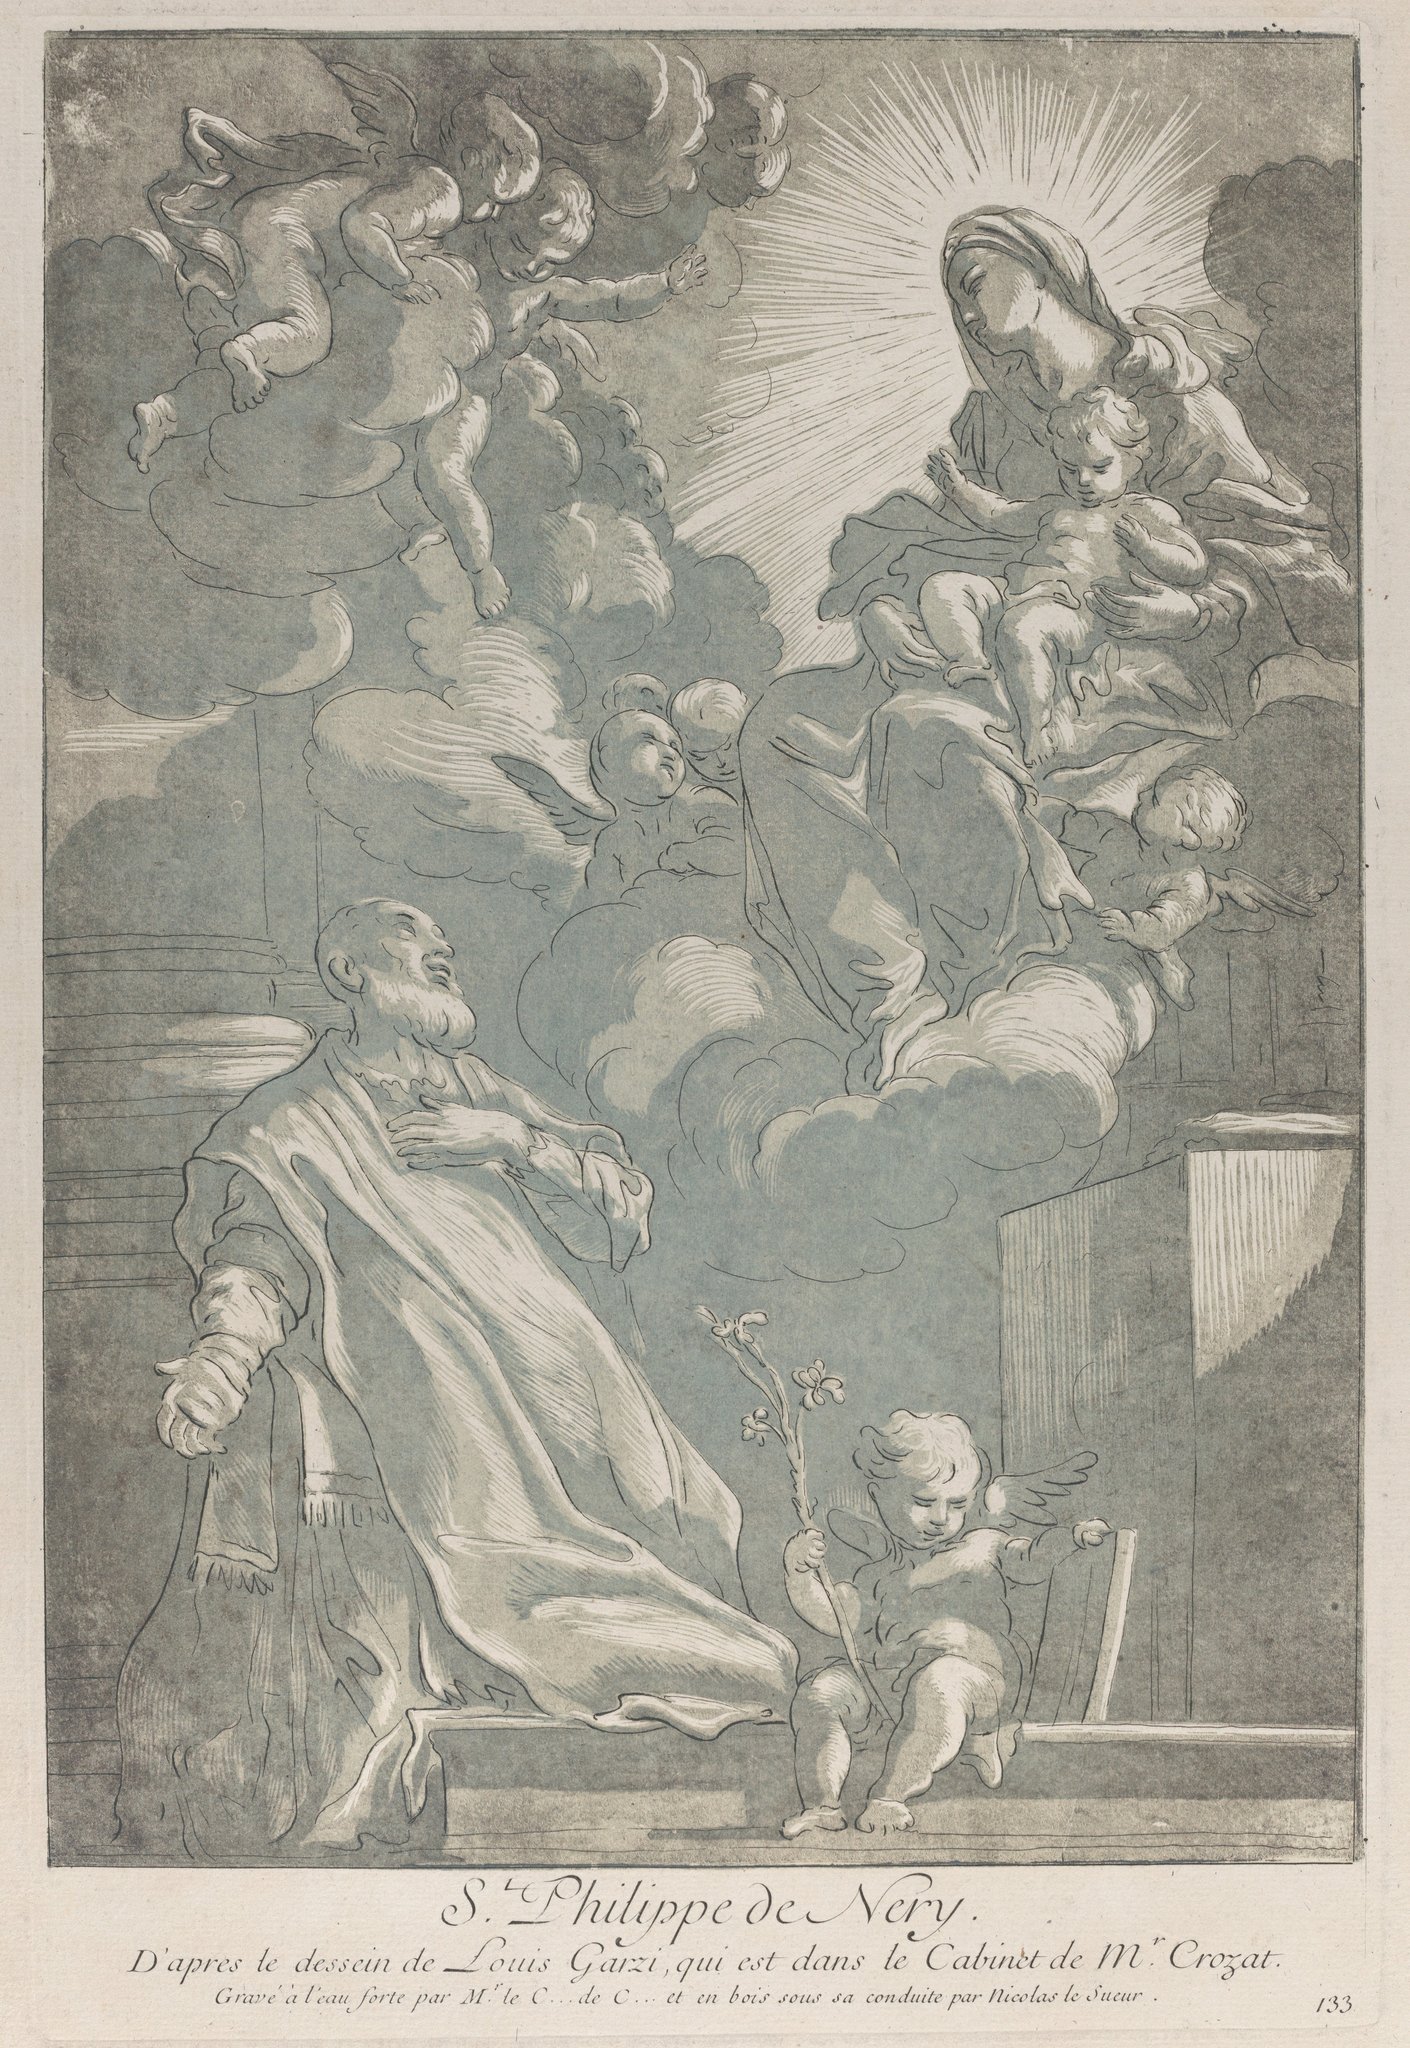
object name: print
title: Saint Philip Neri, kneeling at left, with the Virgin and child appearing at upper right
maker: nicolas le sueur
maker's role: artist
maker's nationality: french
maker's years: 1691-1764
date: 1729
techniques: aquatint, etching